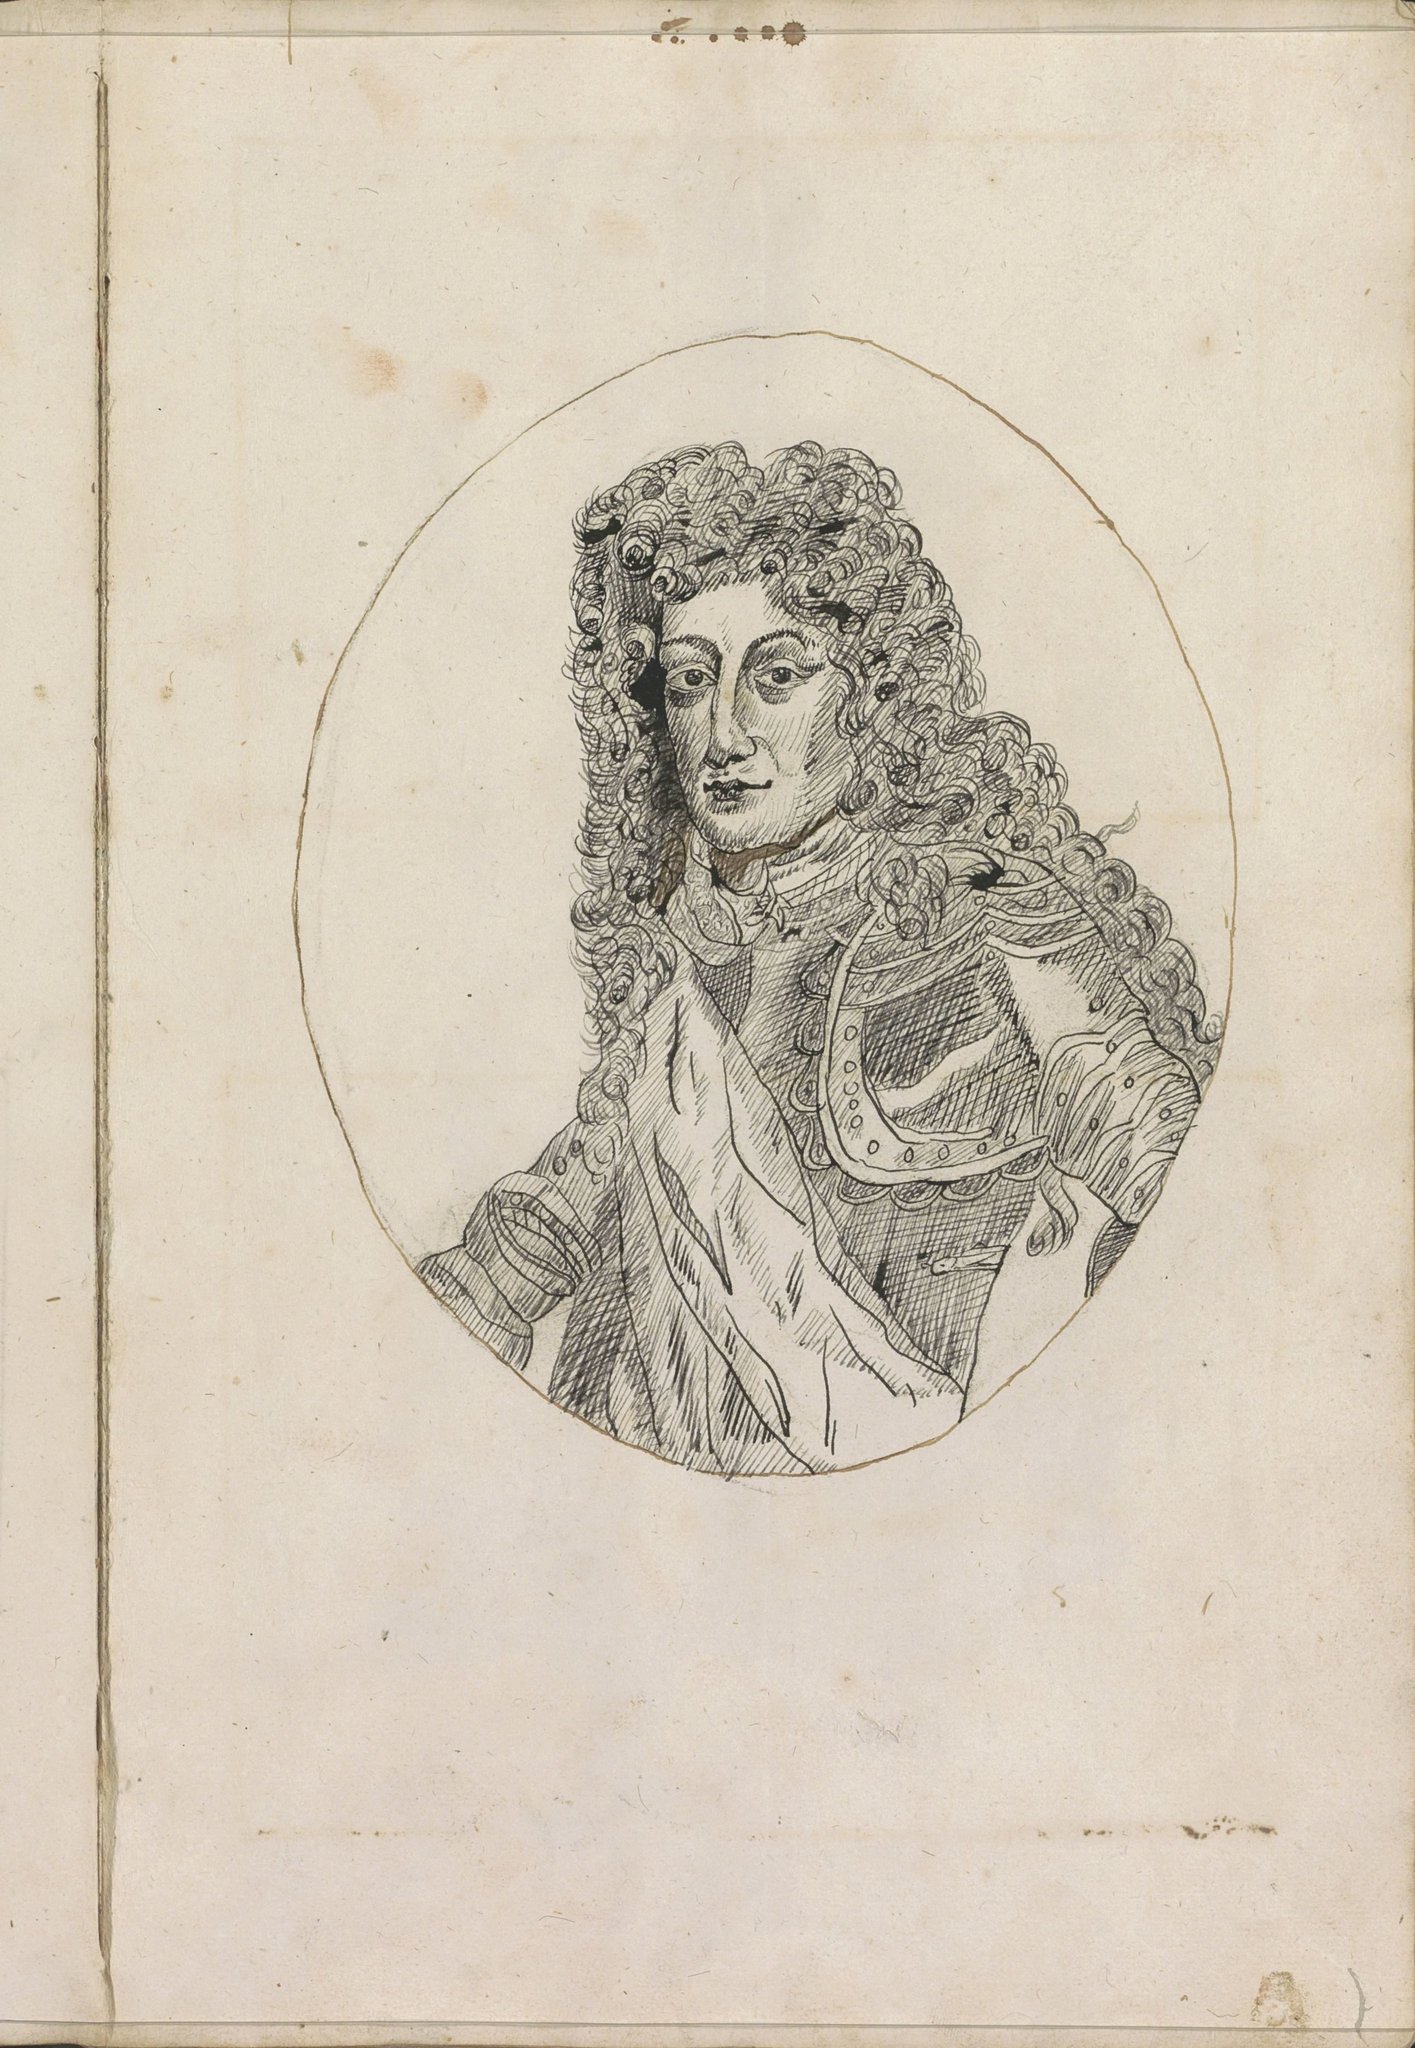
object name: sketchbook leaf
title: Portret van een man in harnas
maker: hendrick van beaumont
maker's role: draughtsman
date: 1696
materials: ink, paper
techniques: brush, pen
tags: harness, anonymous historical person portrayed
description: Portret in een ovaal. Blad 29 recto uit een schetsboek met 91 bladen.